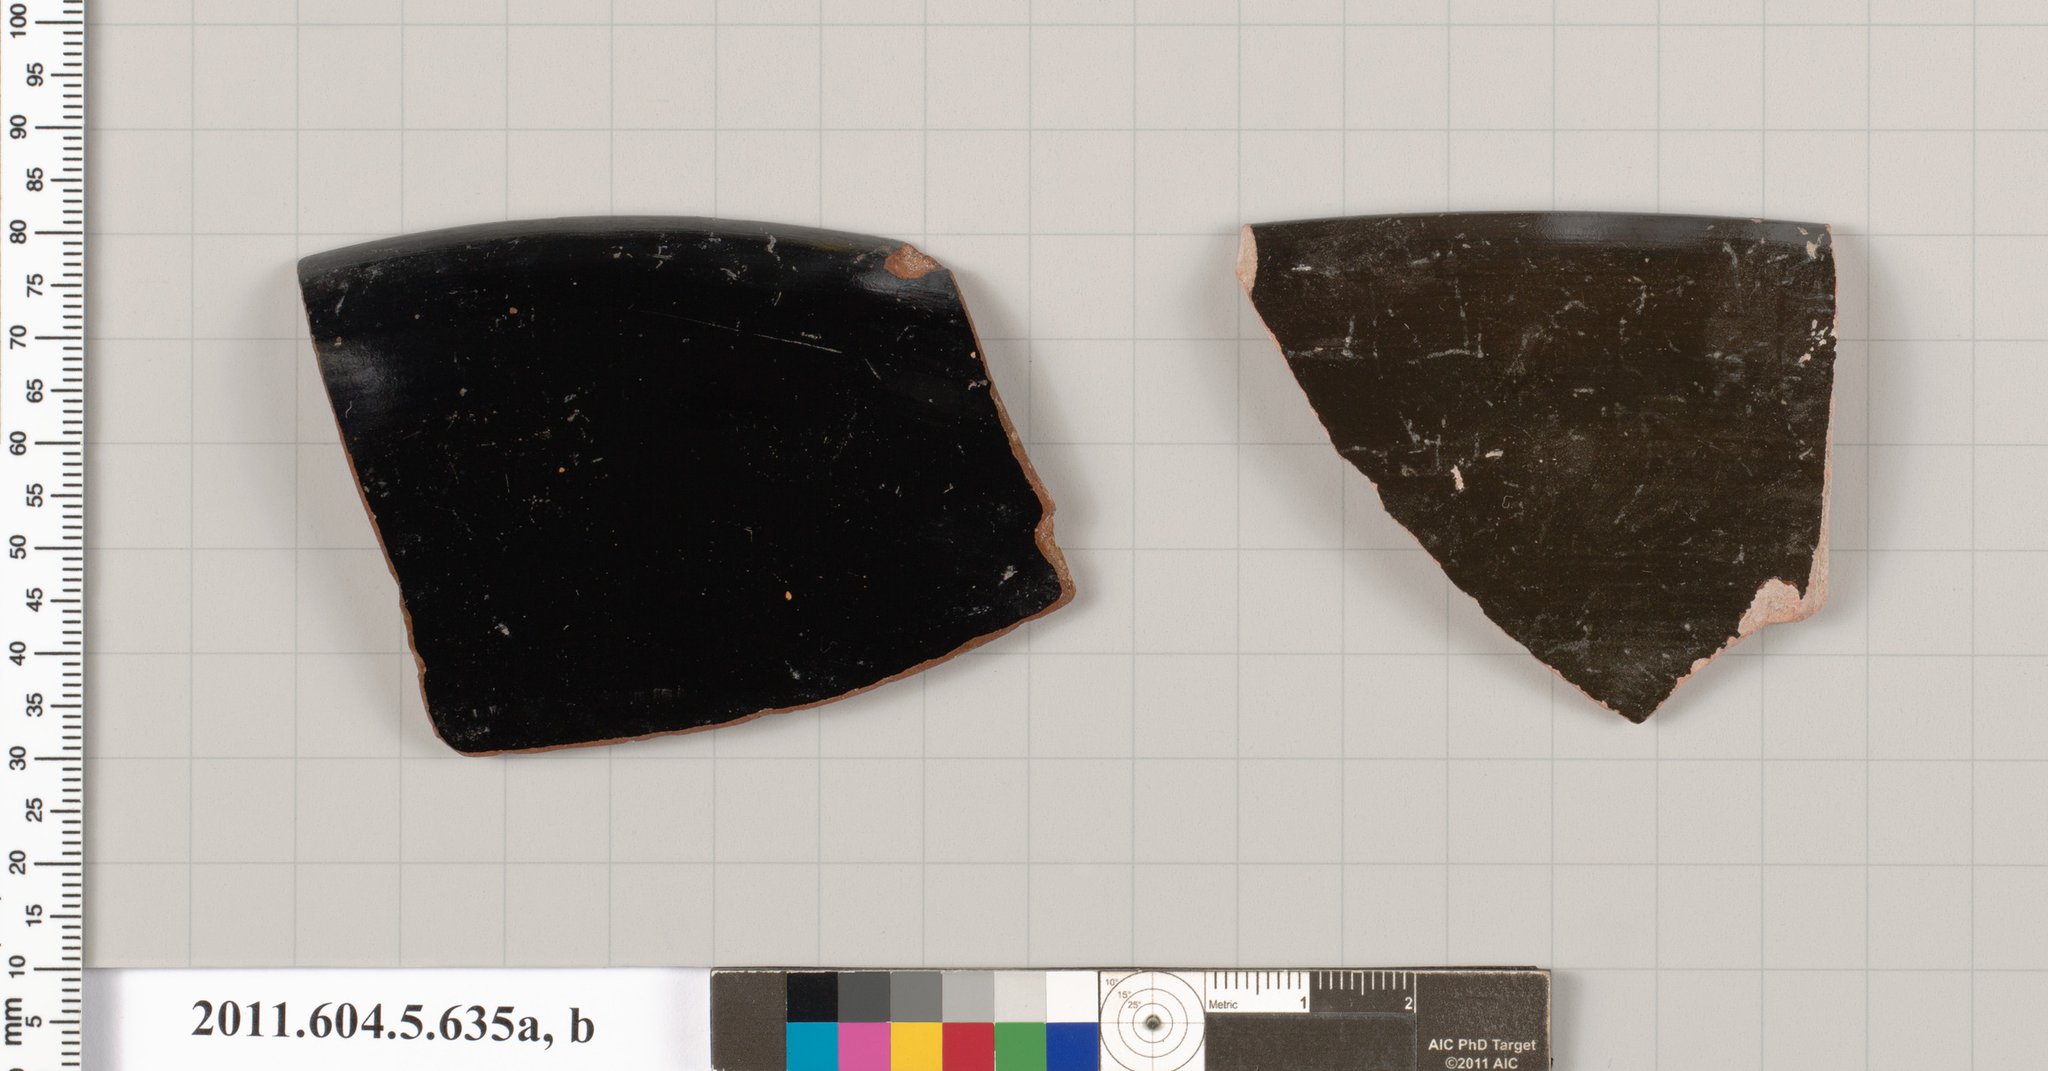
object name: kylix fragment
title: Terracotta rim fragments of kylikes (drinking cups)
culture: greek, attic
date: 600-401 BCE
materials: terracotta